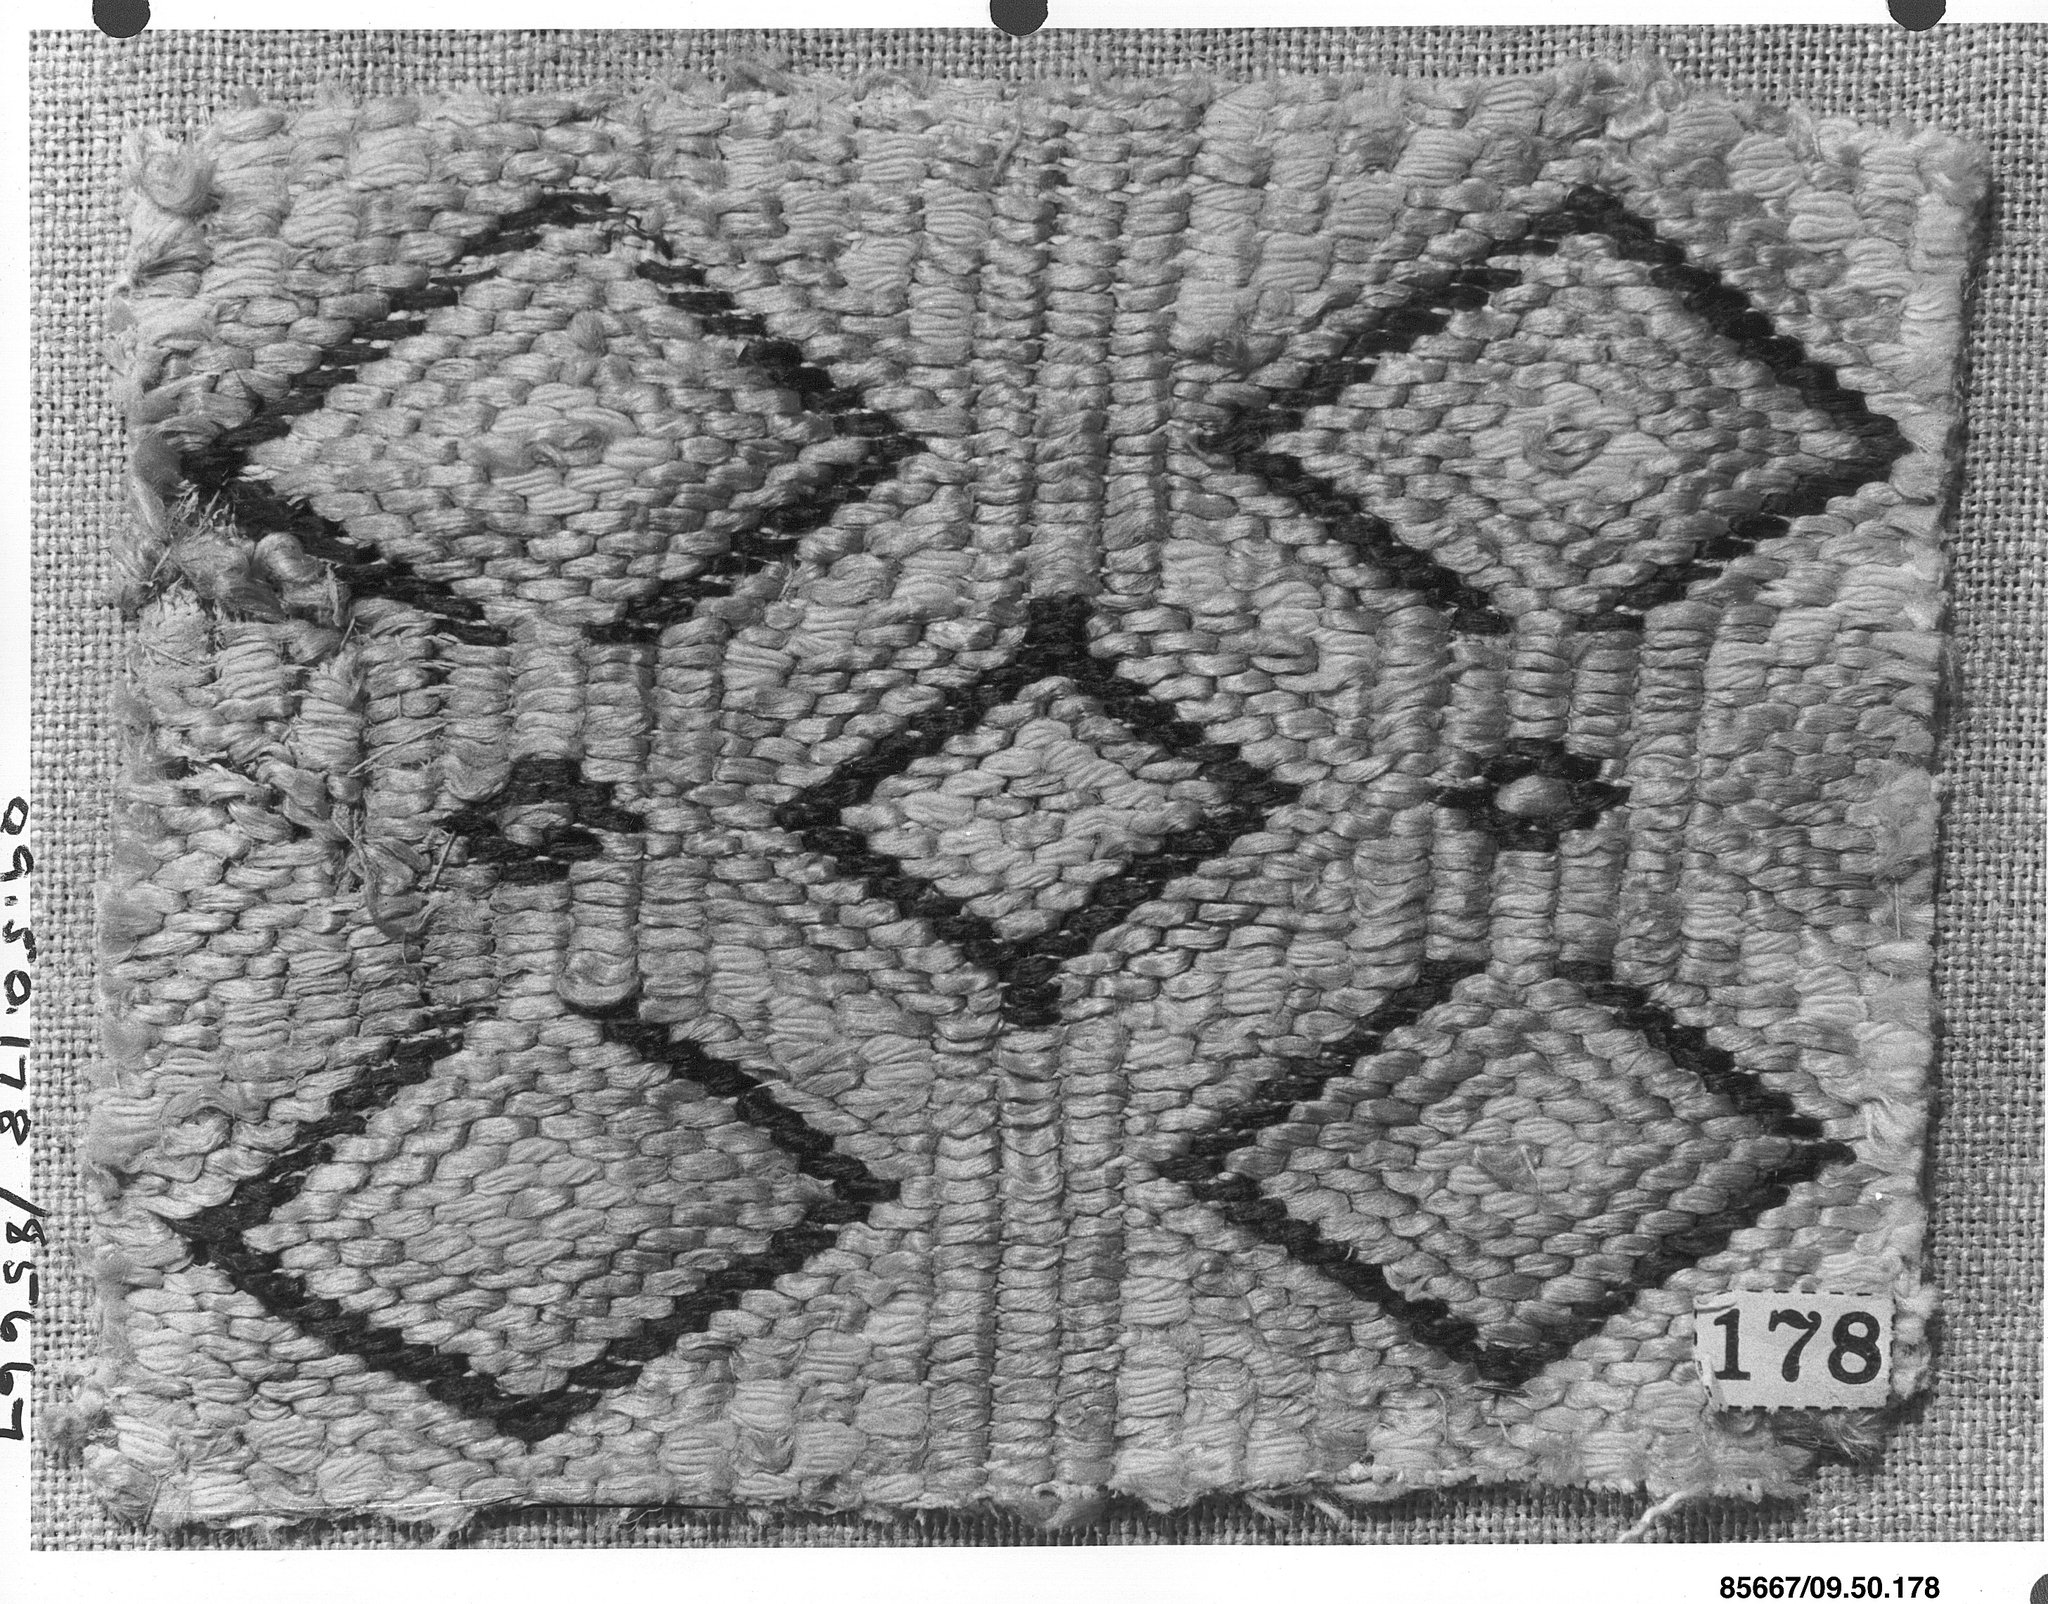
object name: costume fragment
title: Peasant costume fragment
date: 1701-1900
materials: linen, silk